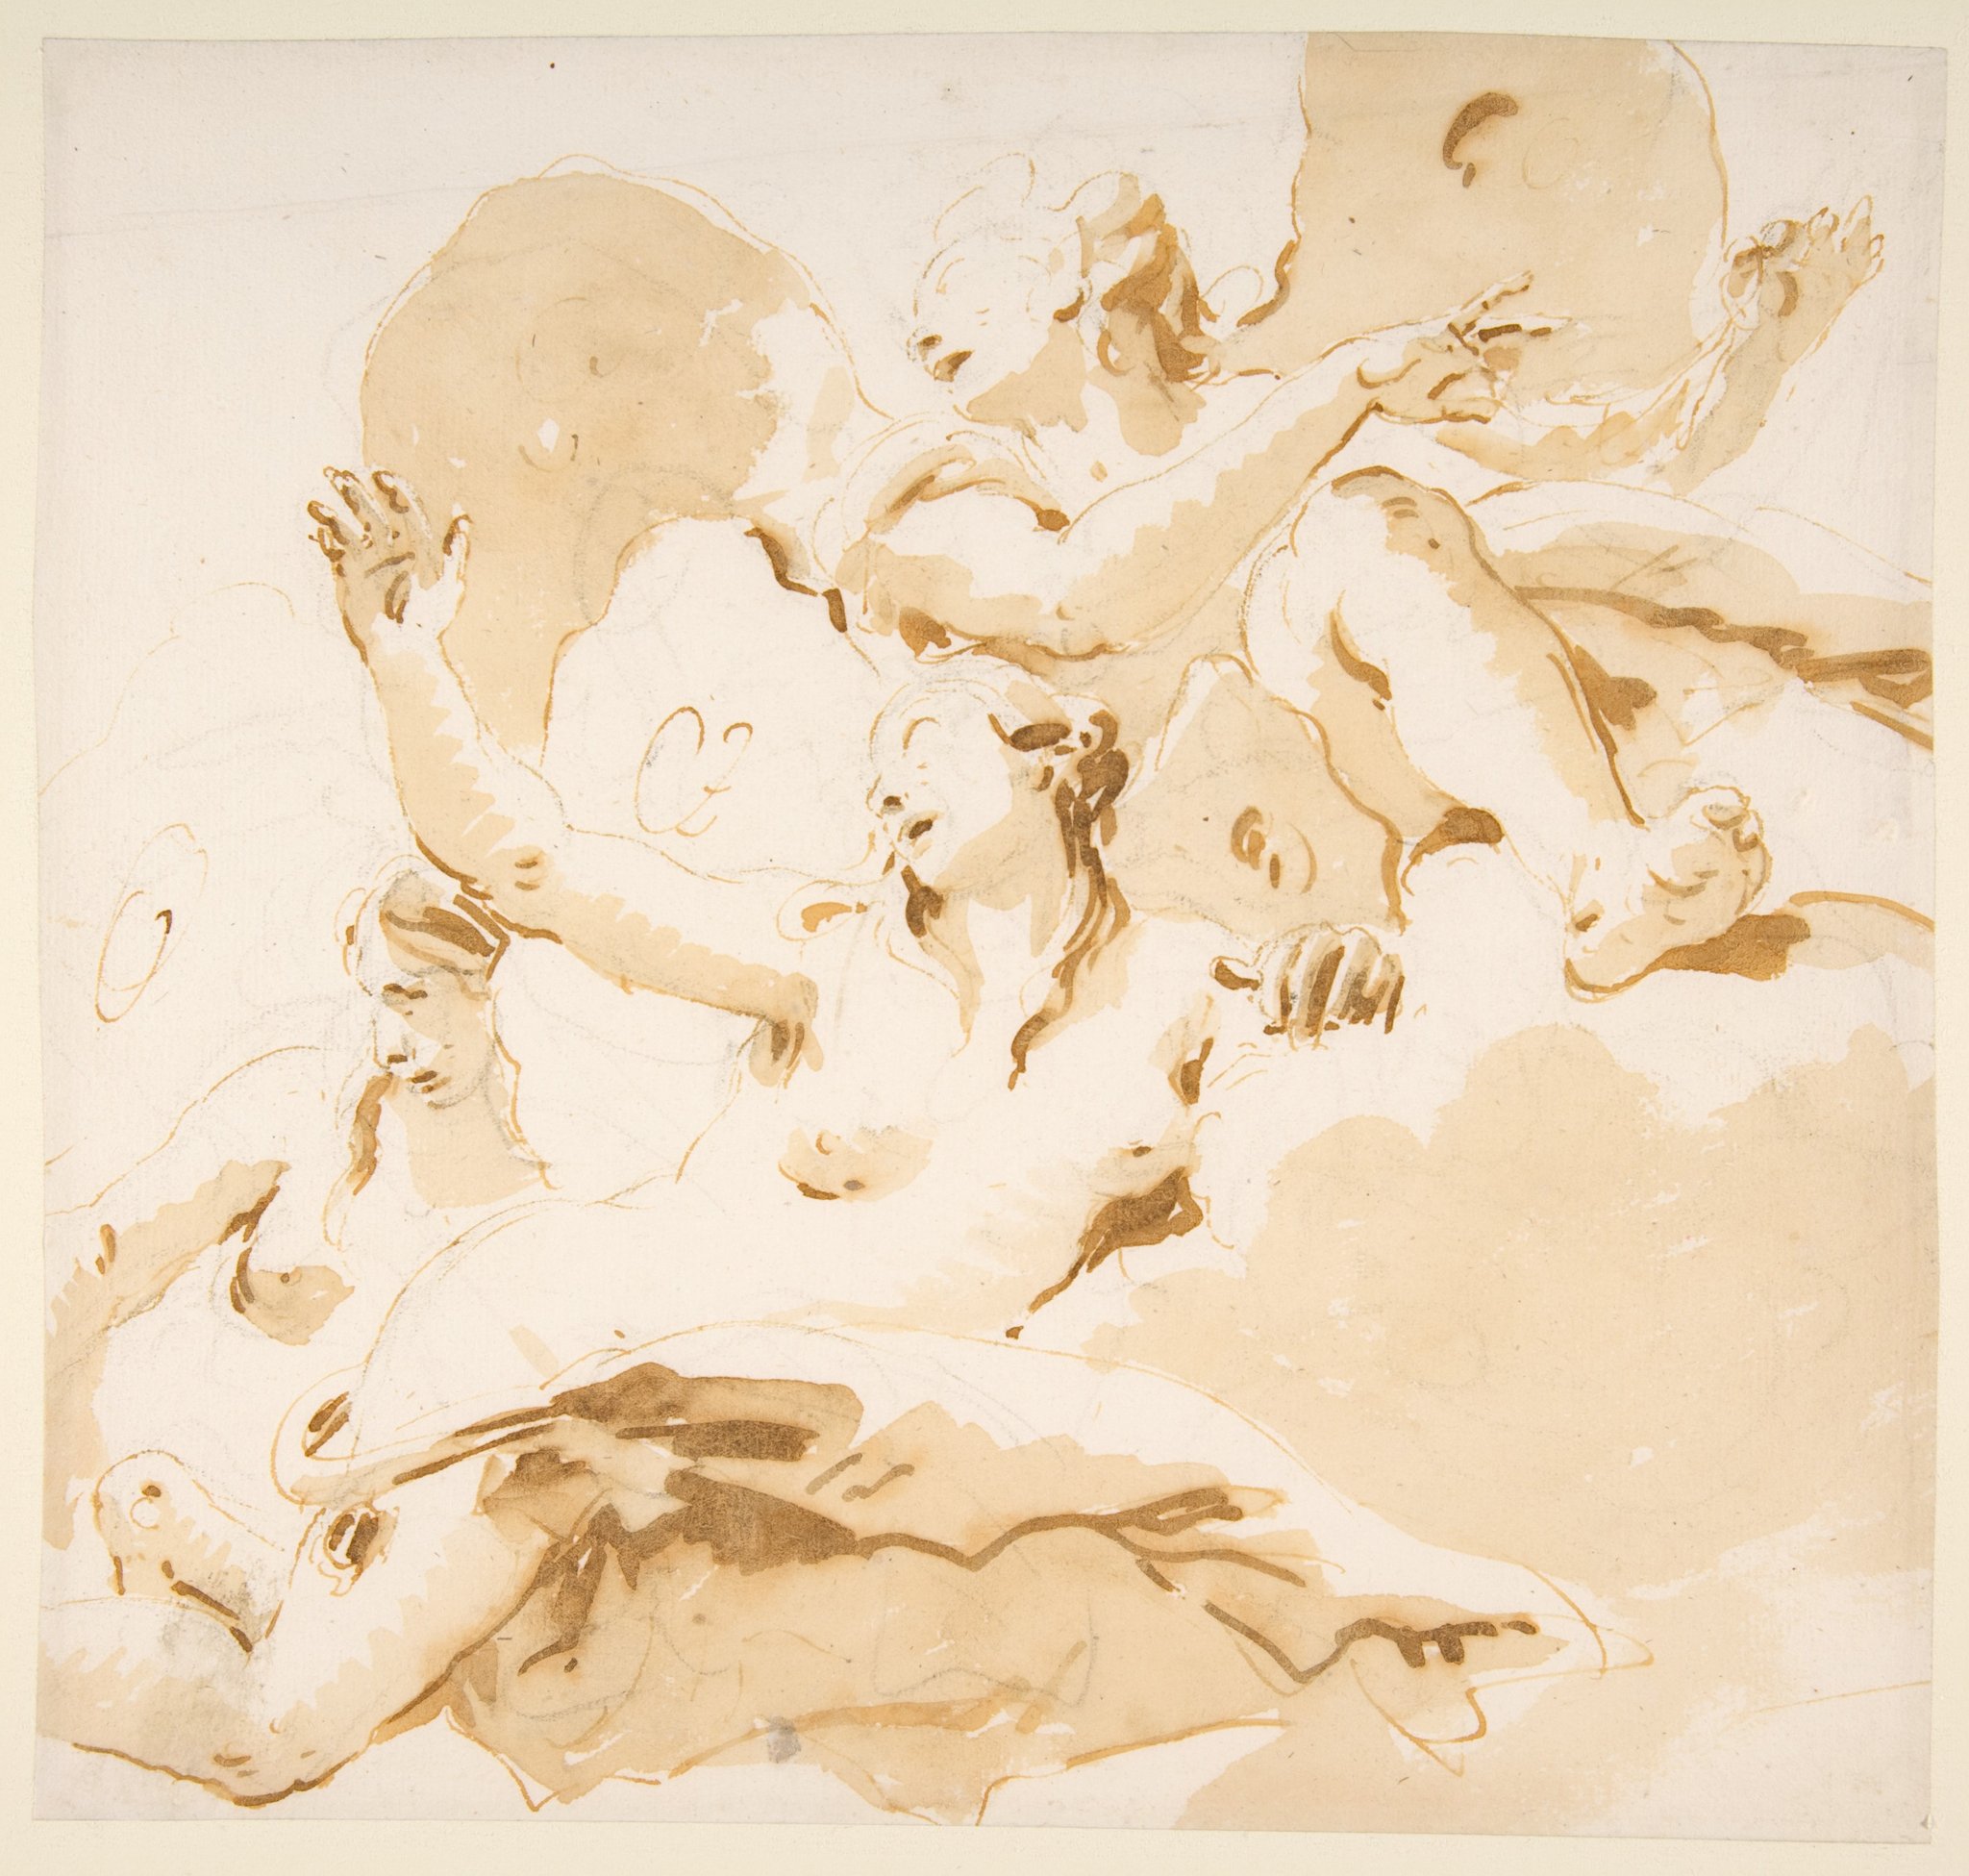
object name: drawing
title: Three Winged Female Figures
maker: giovanni battista tiepolo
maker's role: artist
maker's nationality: italian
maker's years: 1696-1770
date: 1696-1770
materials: chalk, ink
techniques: brush, pen, wash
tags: female nudes